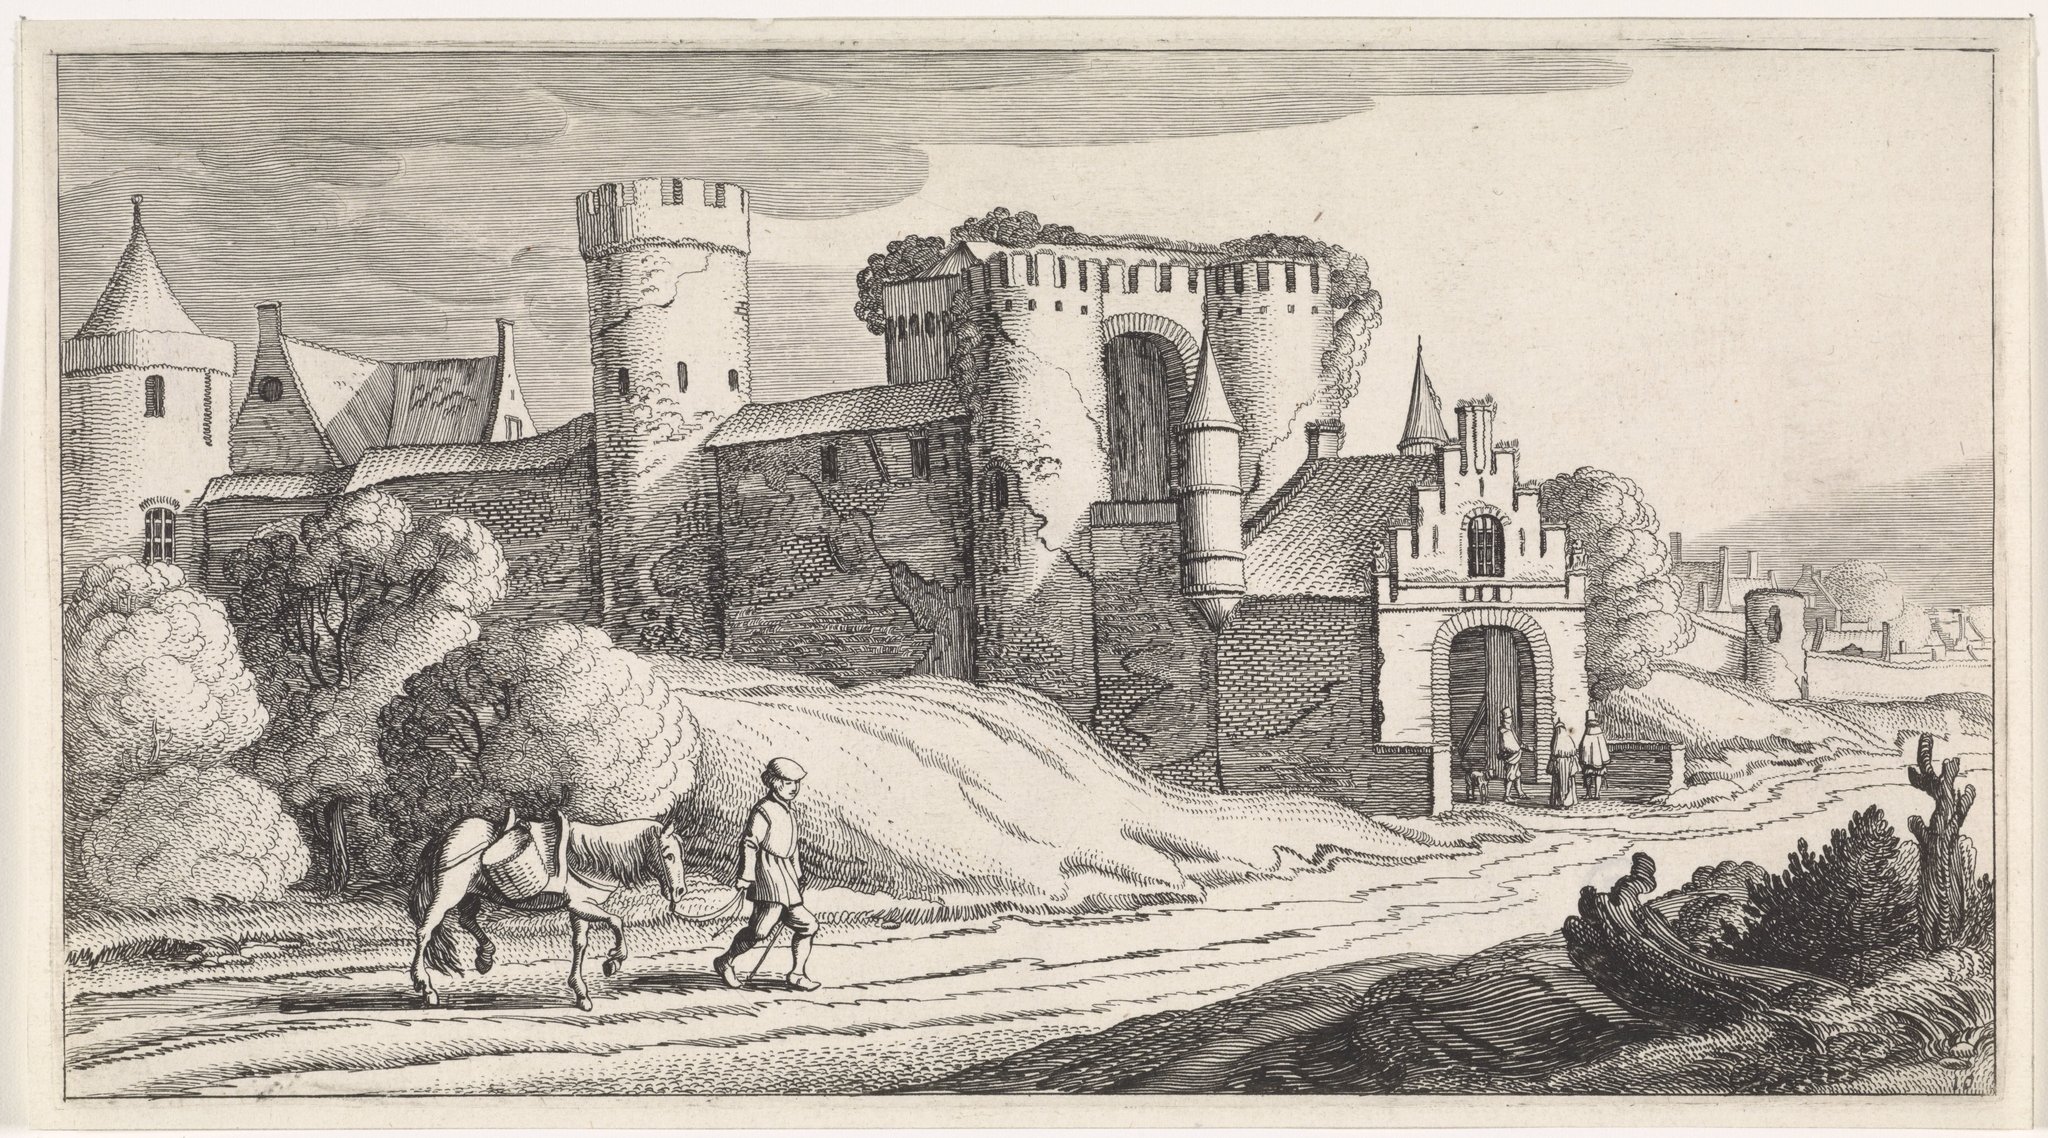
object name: print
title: Playsante lantschappen ende vermakelycke gesichten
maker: jan van de velde (ii)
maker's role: draughtsman, painter, print maker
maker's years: 1593-1641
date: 1639-1641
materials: paper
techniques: etching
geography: northern netherlands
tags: gate, entrance, landscape with tower or castle, leading a horse by the reins; rider beside his horse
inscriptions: collector's mark: Lugt 964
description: Een boer met een paard aan de leidsels op een weg langs een kasteel. Voor de poort van het kasteel drie figuren en een hond. Tiende prent van een serie met 36 prenten van landschappen, verdeeld over zes delen.